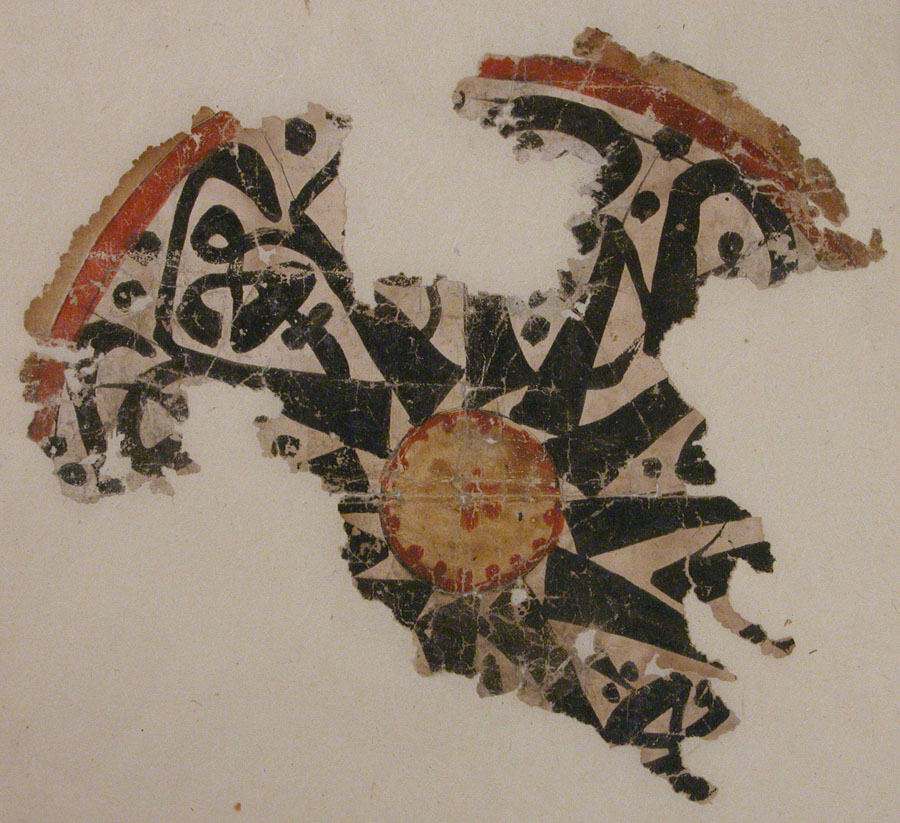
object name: non illustrated single work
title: Calligraphic Fragment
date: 1301-1500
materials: ink, paper, watercolor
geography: egypt